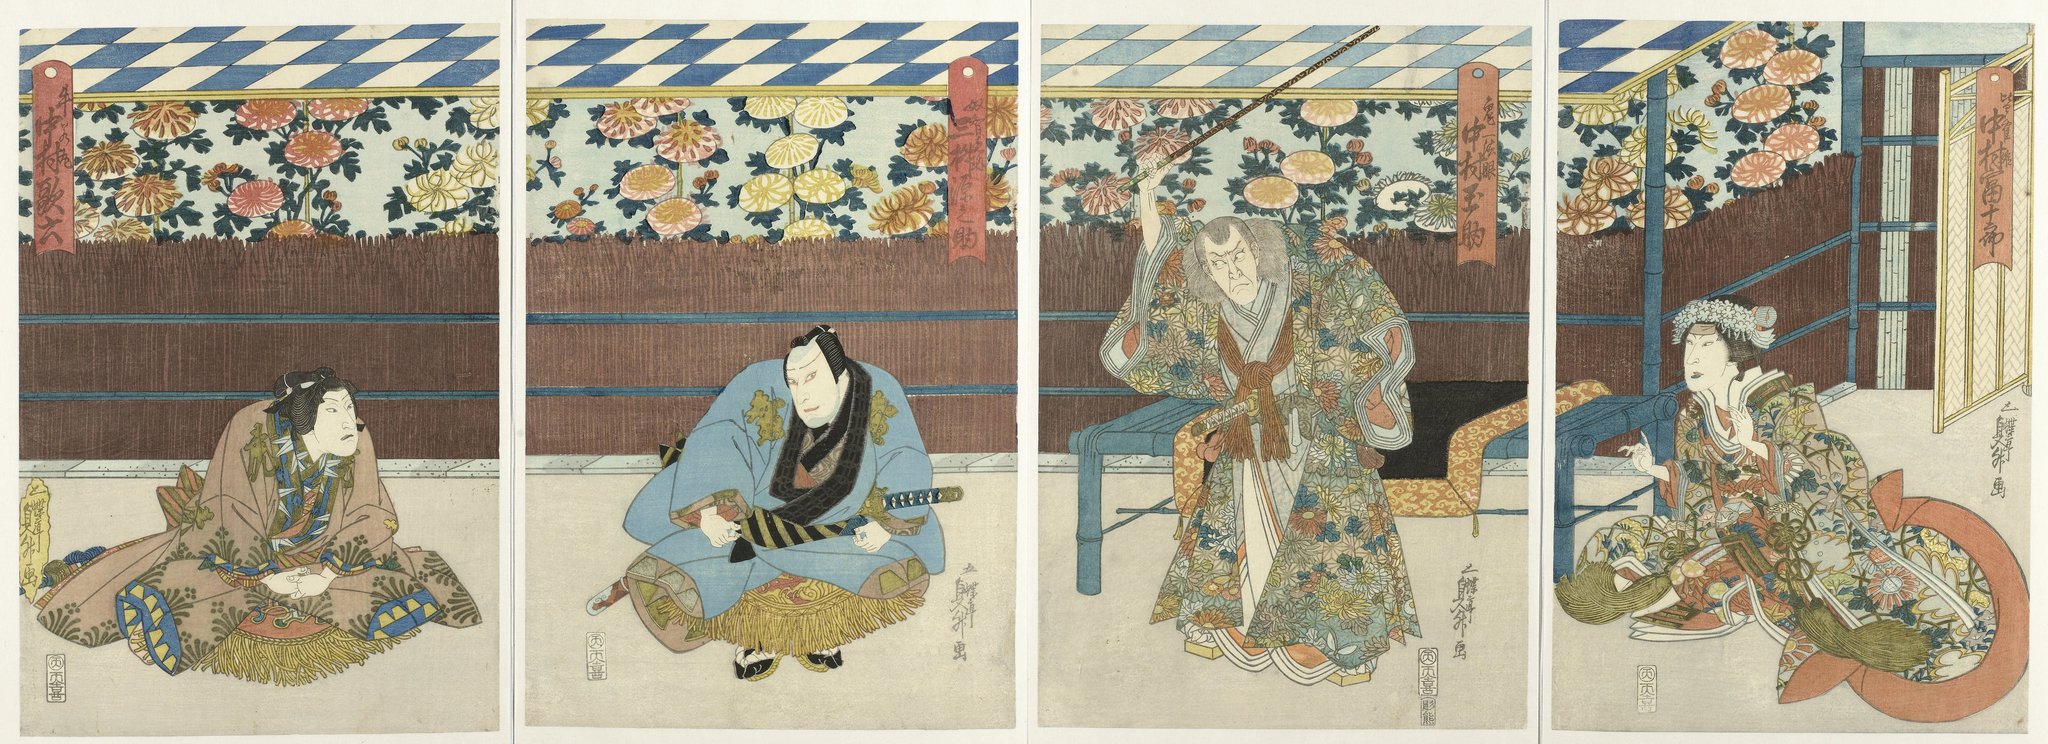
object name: print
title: Vier toneelspelers bij een herfstbloemen tentoonstelling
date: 1809-1837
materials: paper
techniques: woodcut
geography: osaka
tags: flowers, portrait of actor, actress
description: Vierluik met op elk blad een toneelspeler bij een houten hek, waarachter een tentoonstelling van herfstbloemen. V.l.n.r. Nakamura Karoku I in de rol van Ushiwakamaru, Mimasu Gennosuke I als dienaar Chienai, Nakamura Tamasuke I (Utaemon III) als Kiichi Hôgen en Nakamura Tomijûrô II als Minazuru-hime, in het stuk ‘Kiichi Hôgen sanryaku no maki’, opgevoerd in het Naka Theater, in de negende maand van 1837.